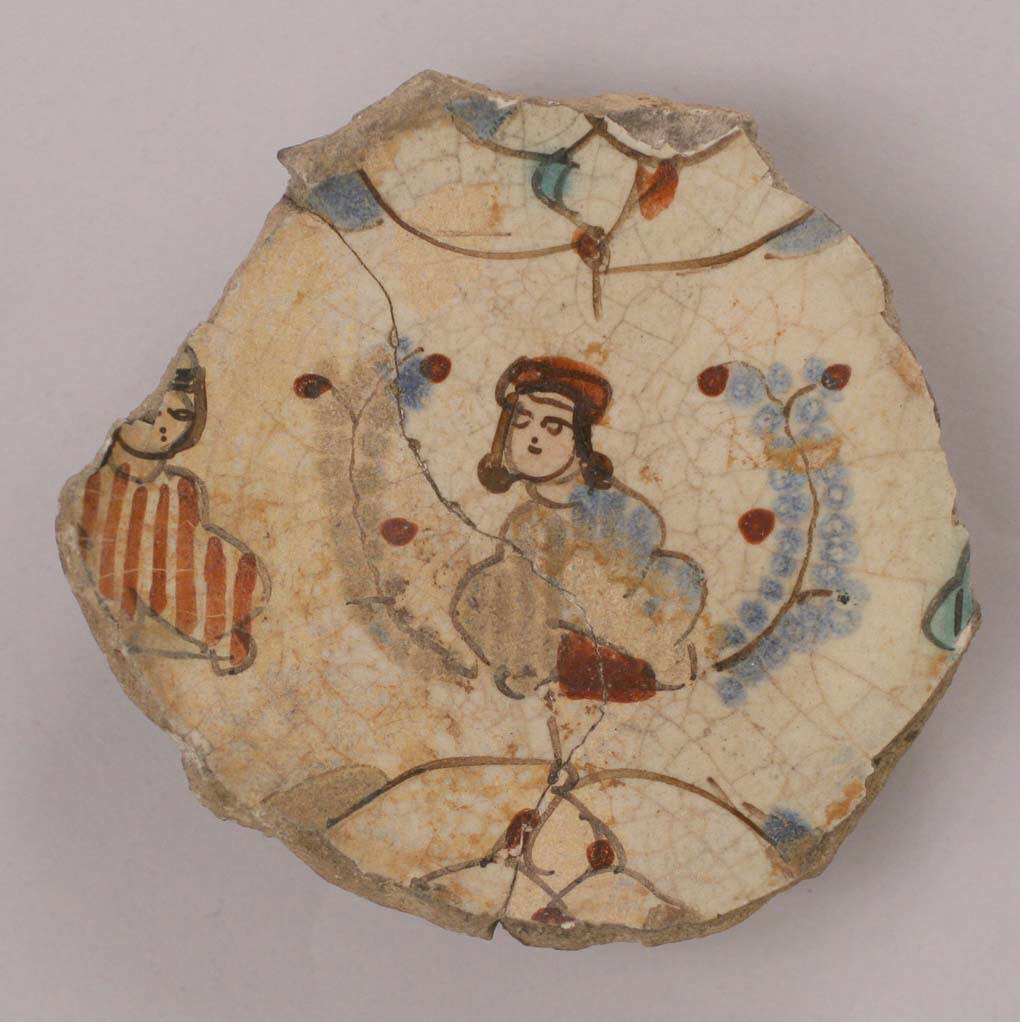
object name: fragment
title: Fragment of a Bowl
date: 1101-1300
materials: stonepaste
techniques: overglaze, painting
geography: iran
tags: human figures